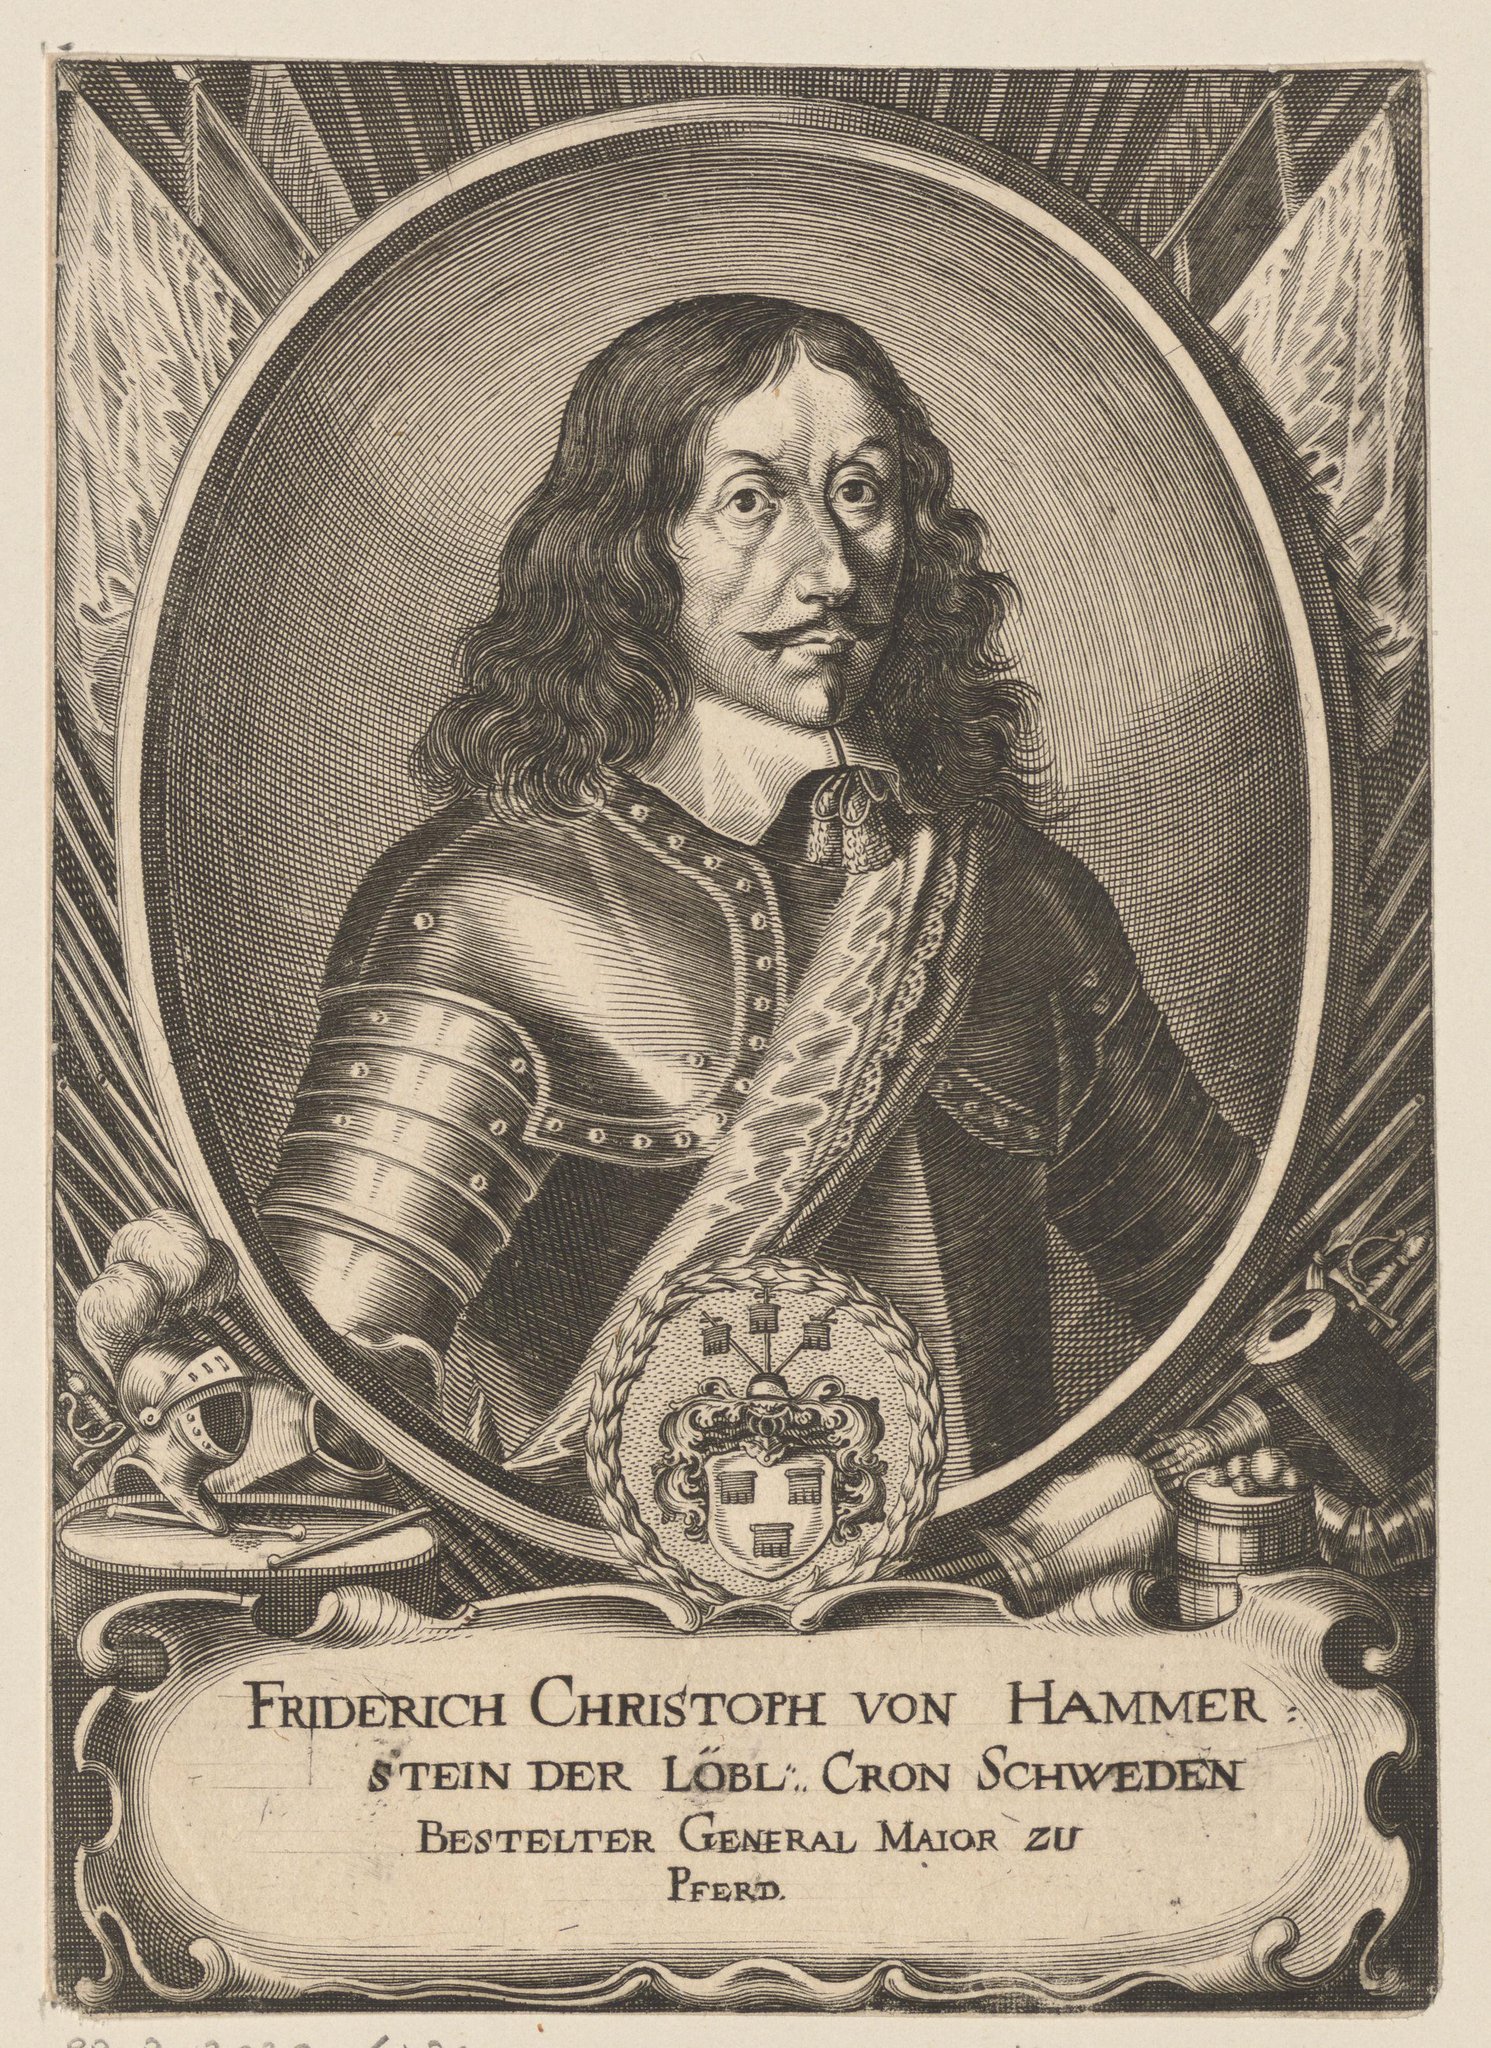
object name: book illustration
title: Portret van Friedrich Christoph von Hammerstein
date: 1652-1663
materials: paper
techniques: engraving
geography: frankfurt am main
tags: helmet, armour, historical persons, armorial bearing, heraldry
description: Prent gebruikt in: Theatrum Europaeum. Frankfurt am Main: erven Matthäus Merian, 1652, dl. 6. Prent opnieuw gebruikt in de tweede editie van 1663